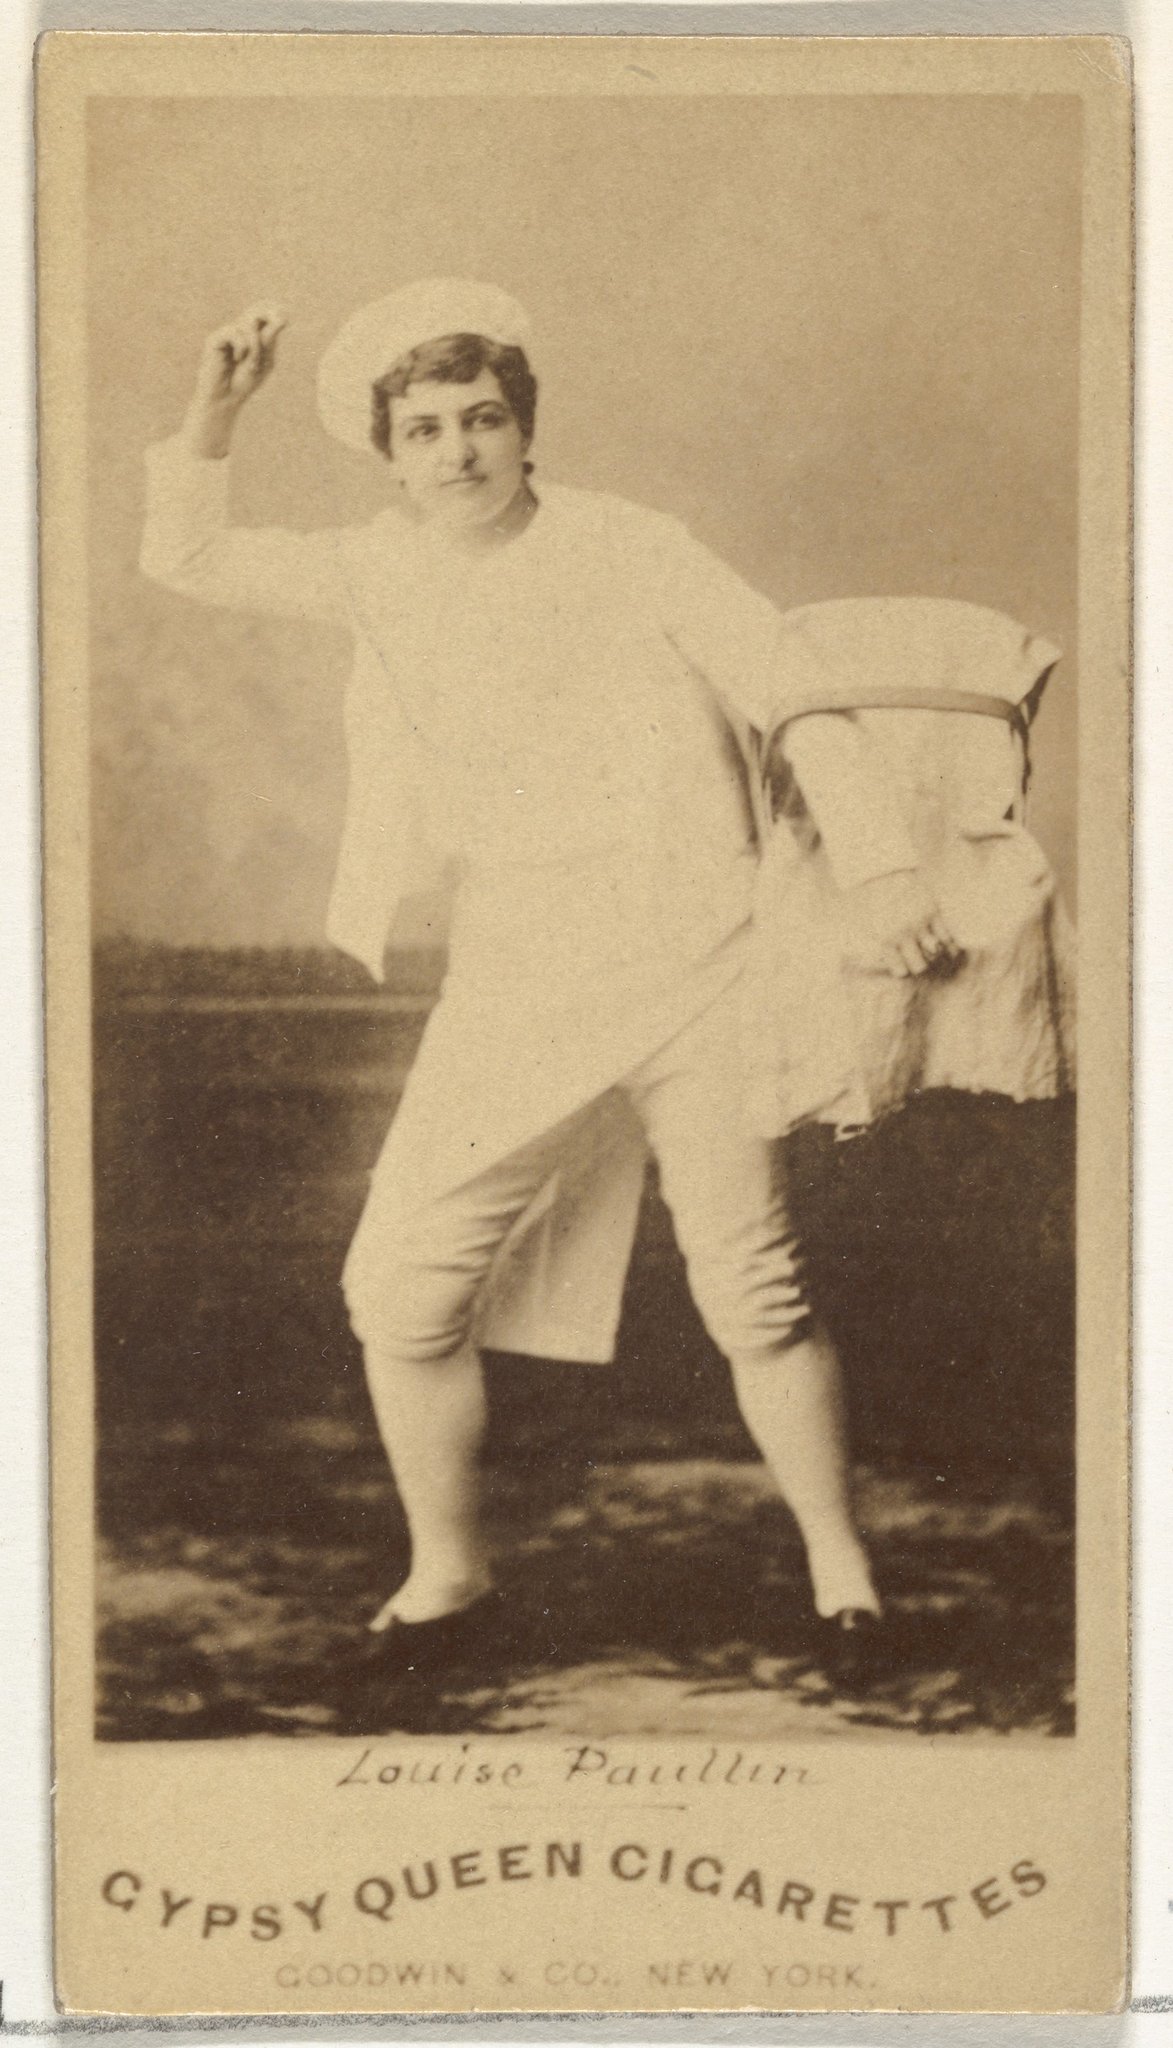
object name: photograph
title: Louise Paullin, from the Actors and Actresses series (N171) for Gypsy Queen Cigarettes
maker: goodwin & company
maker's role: publisher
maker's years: 1850-1950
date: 1886-1890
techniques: albumen silver print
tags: portraits,women,actresses